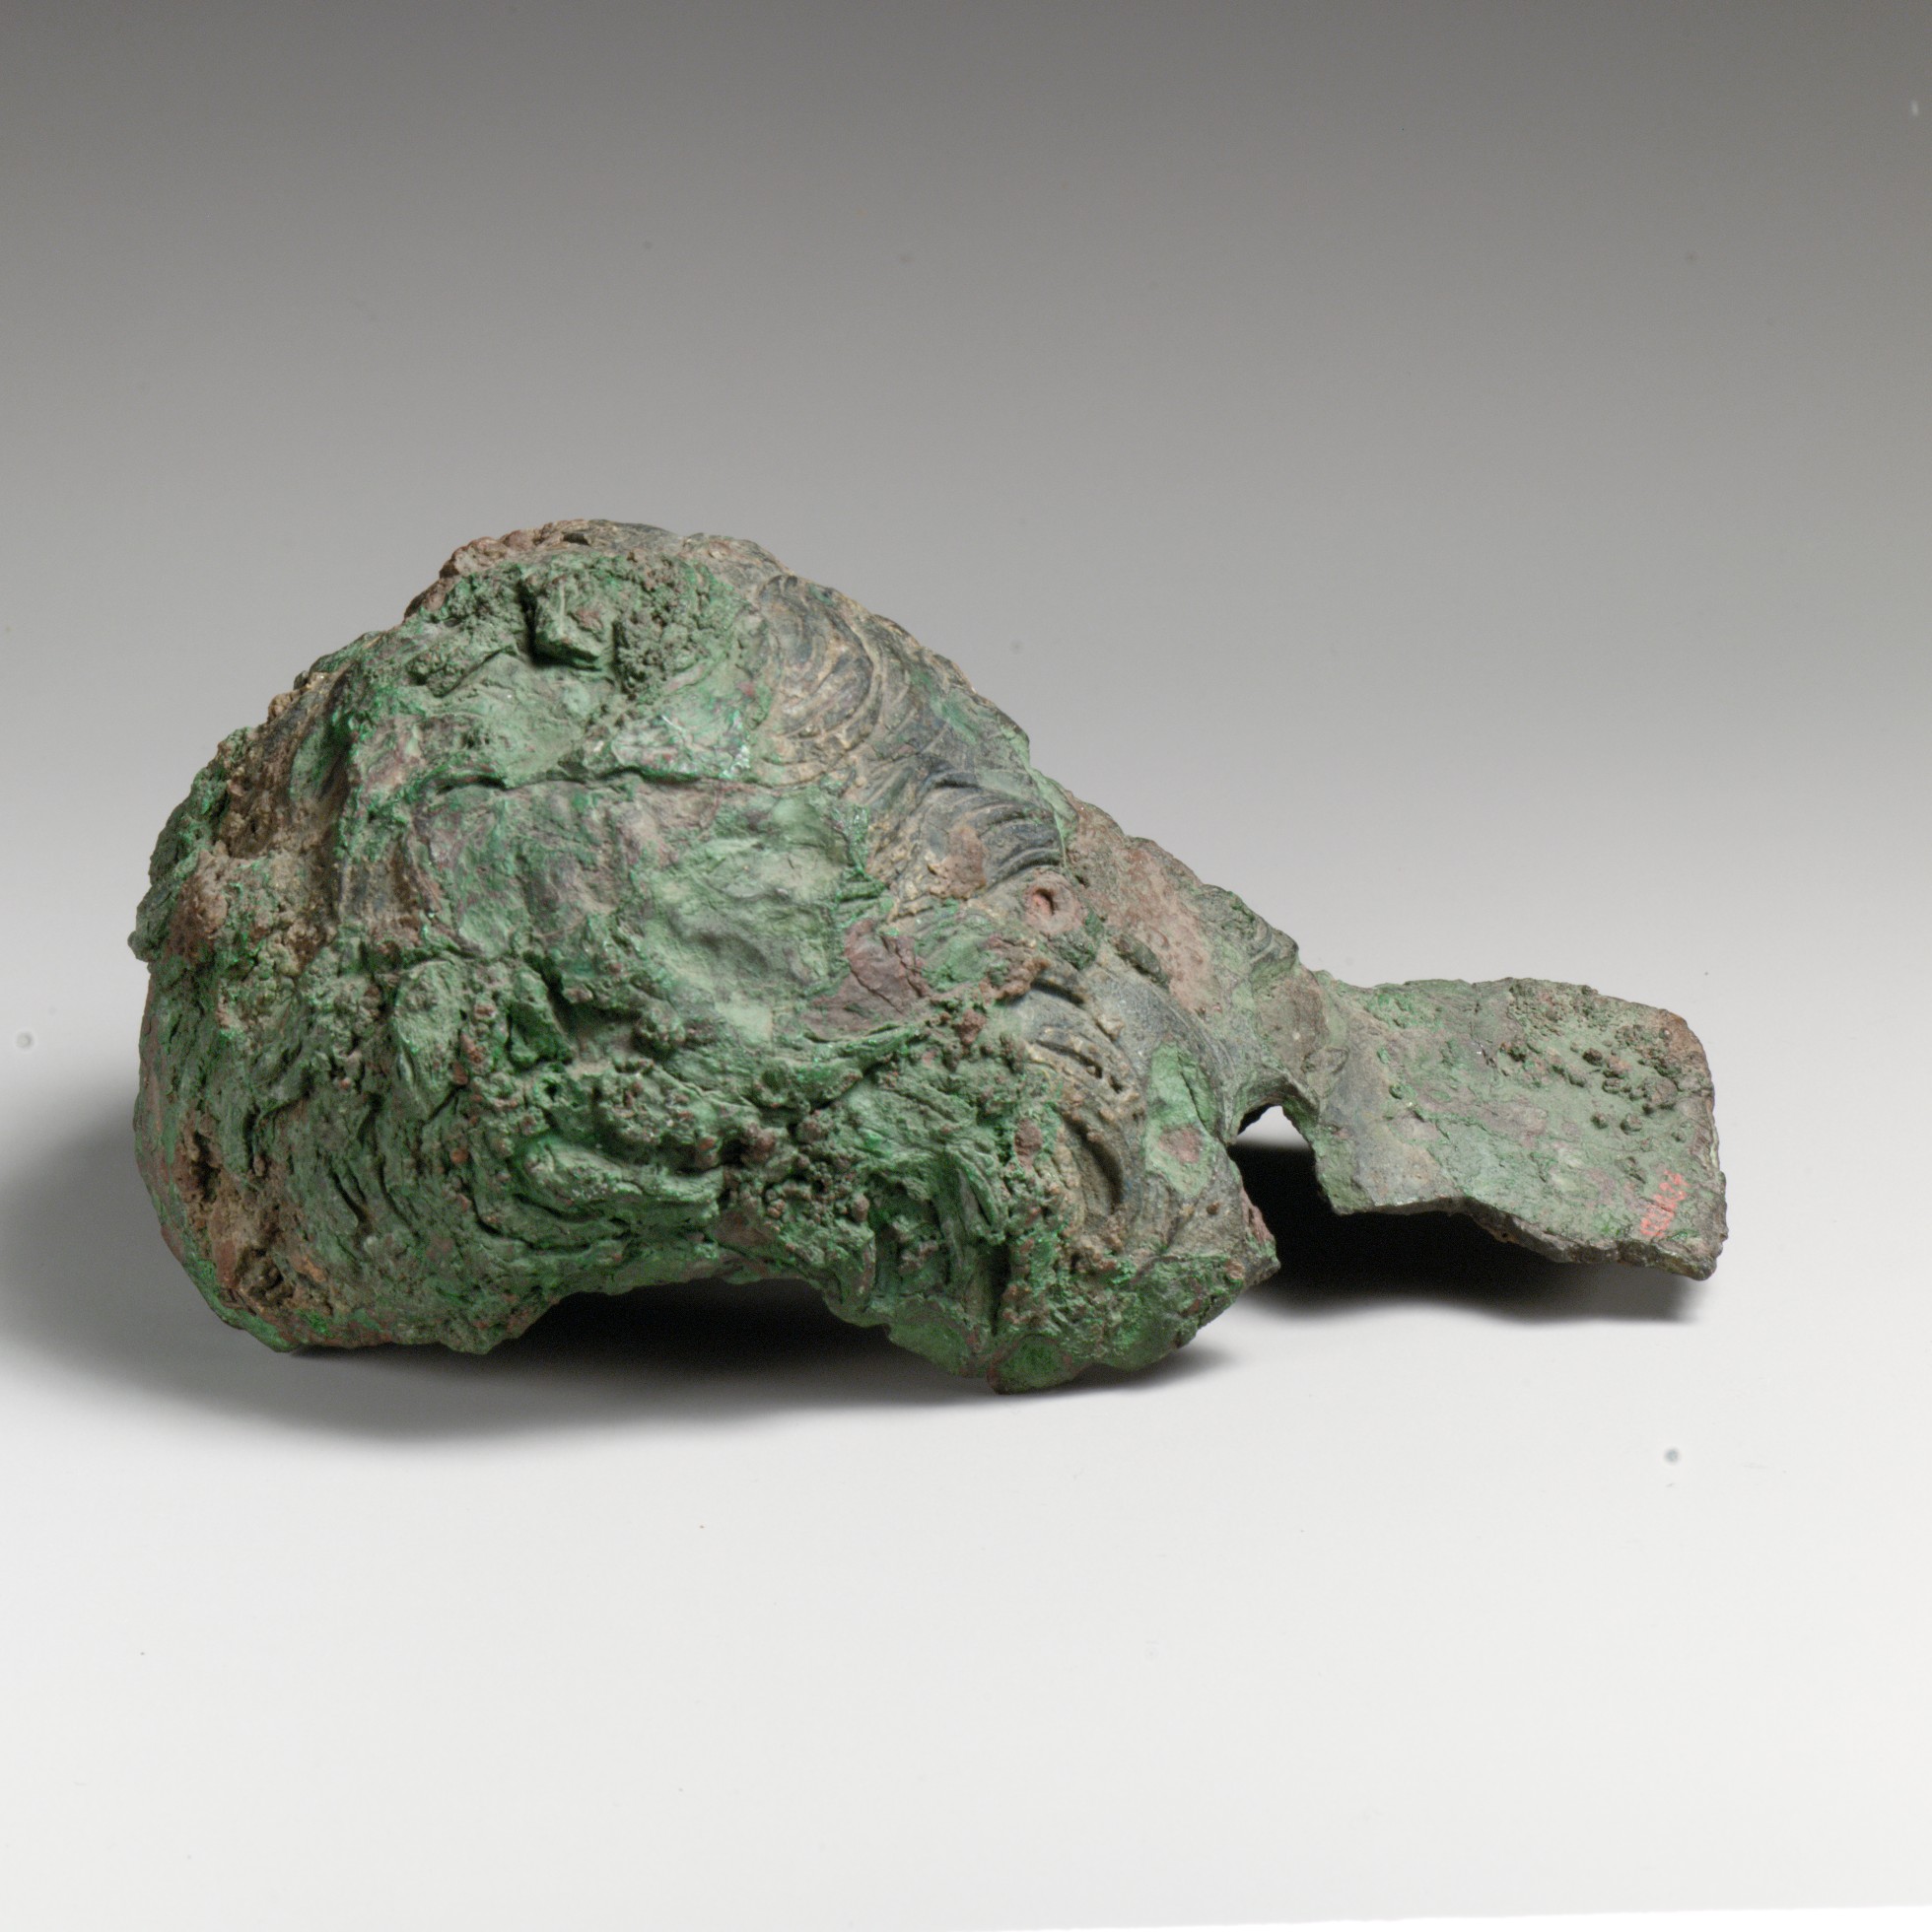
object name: head back, including ear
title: Head-back, including ear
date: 7000 BCE-330 CE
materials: bronze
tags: heads